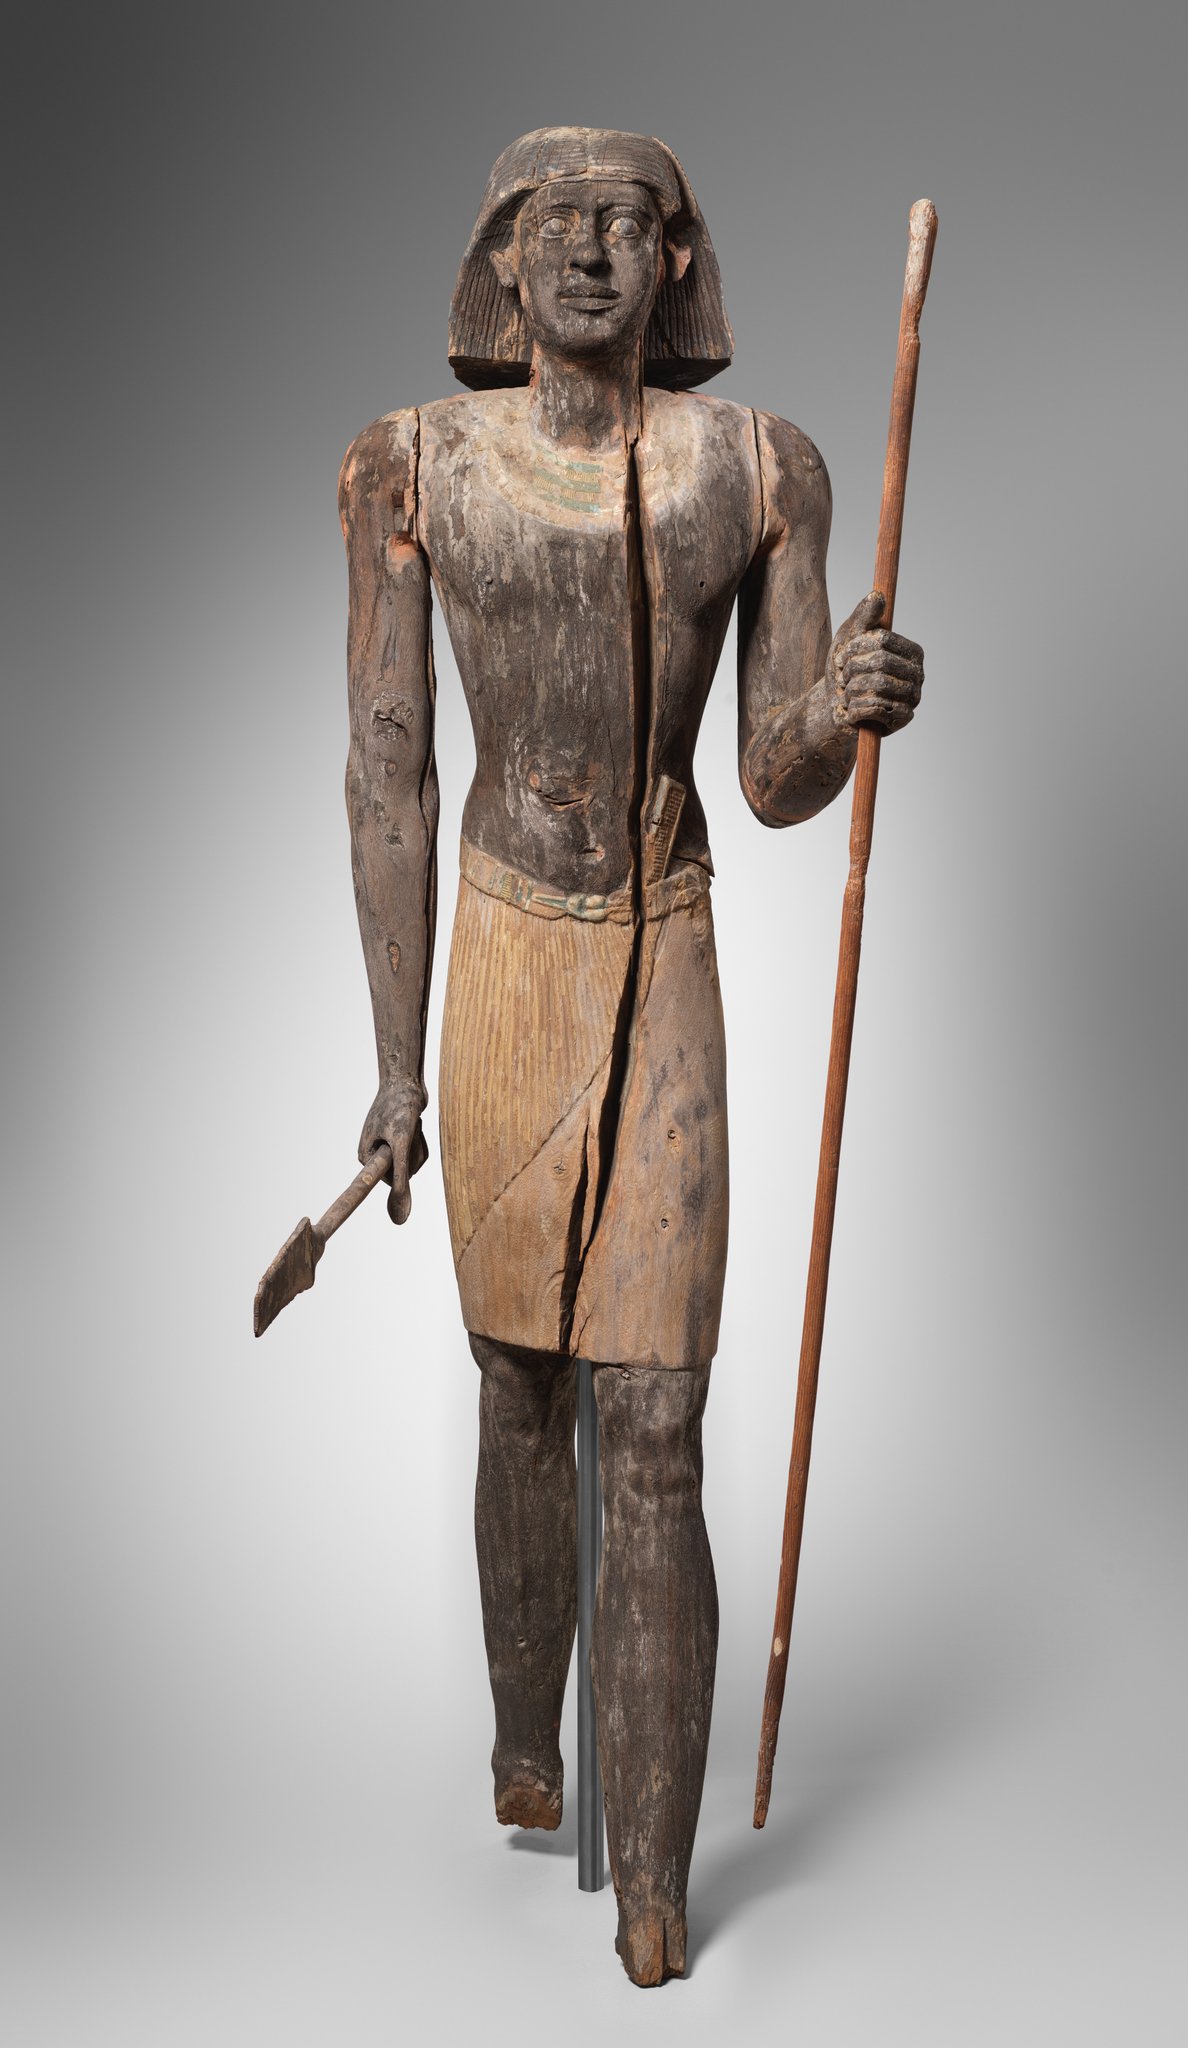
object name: statue, merti, flaring wig, mitry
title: Standing Statue of Mitry with flaring wig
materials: gesso, paint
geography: egypt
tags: men